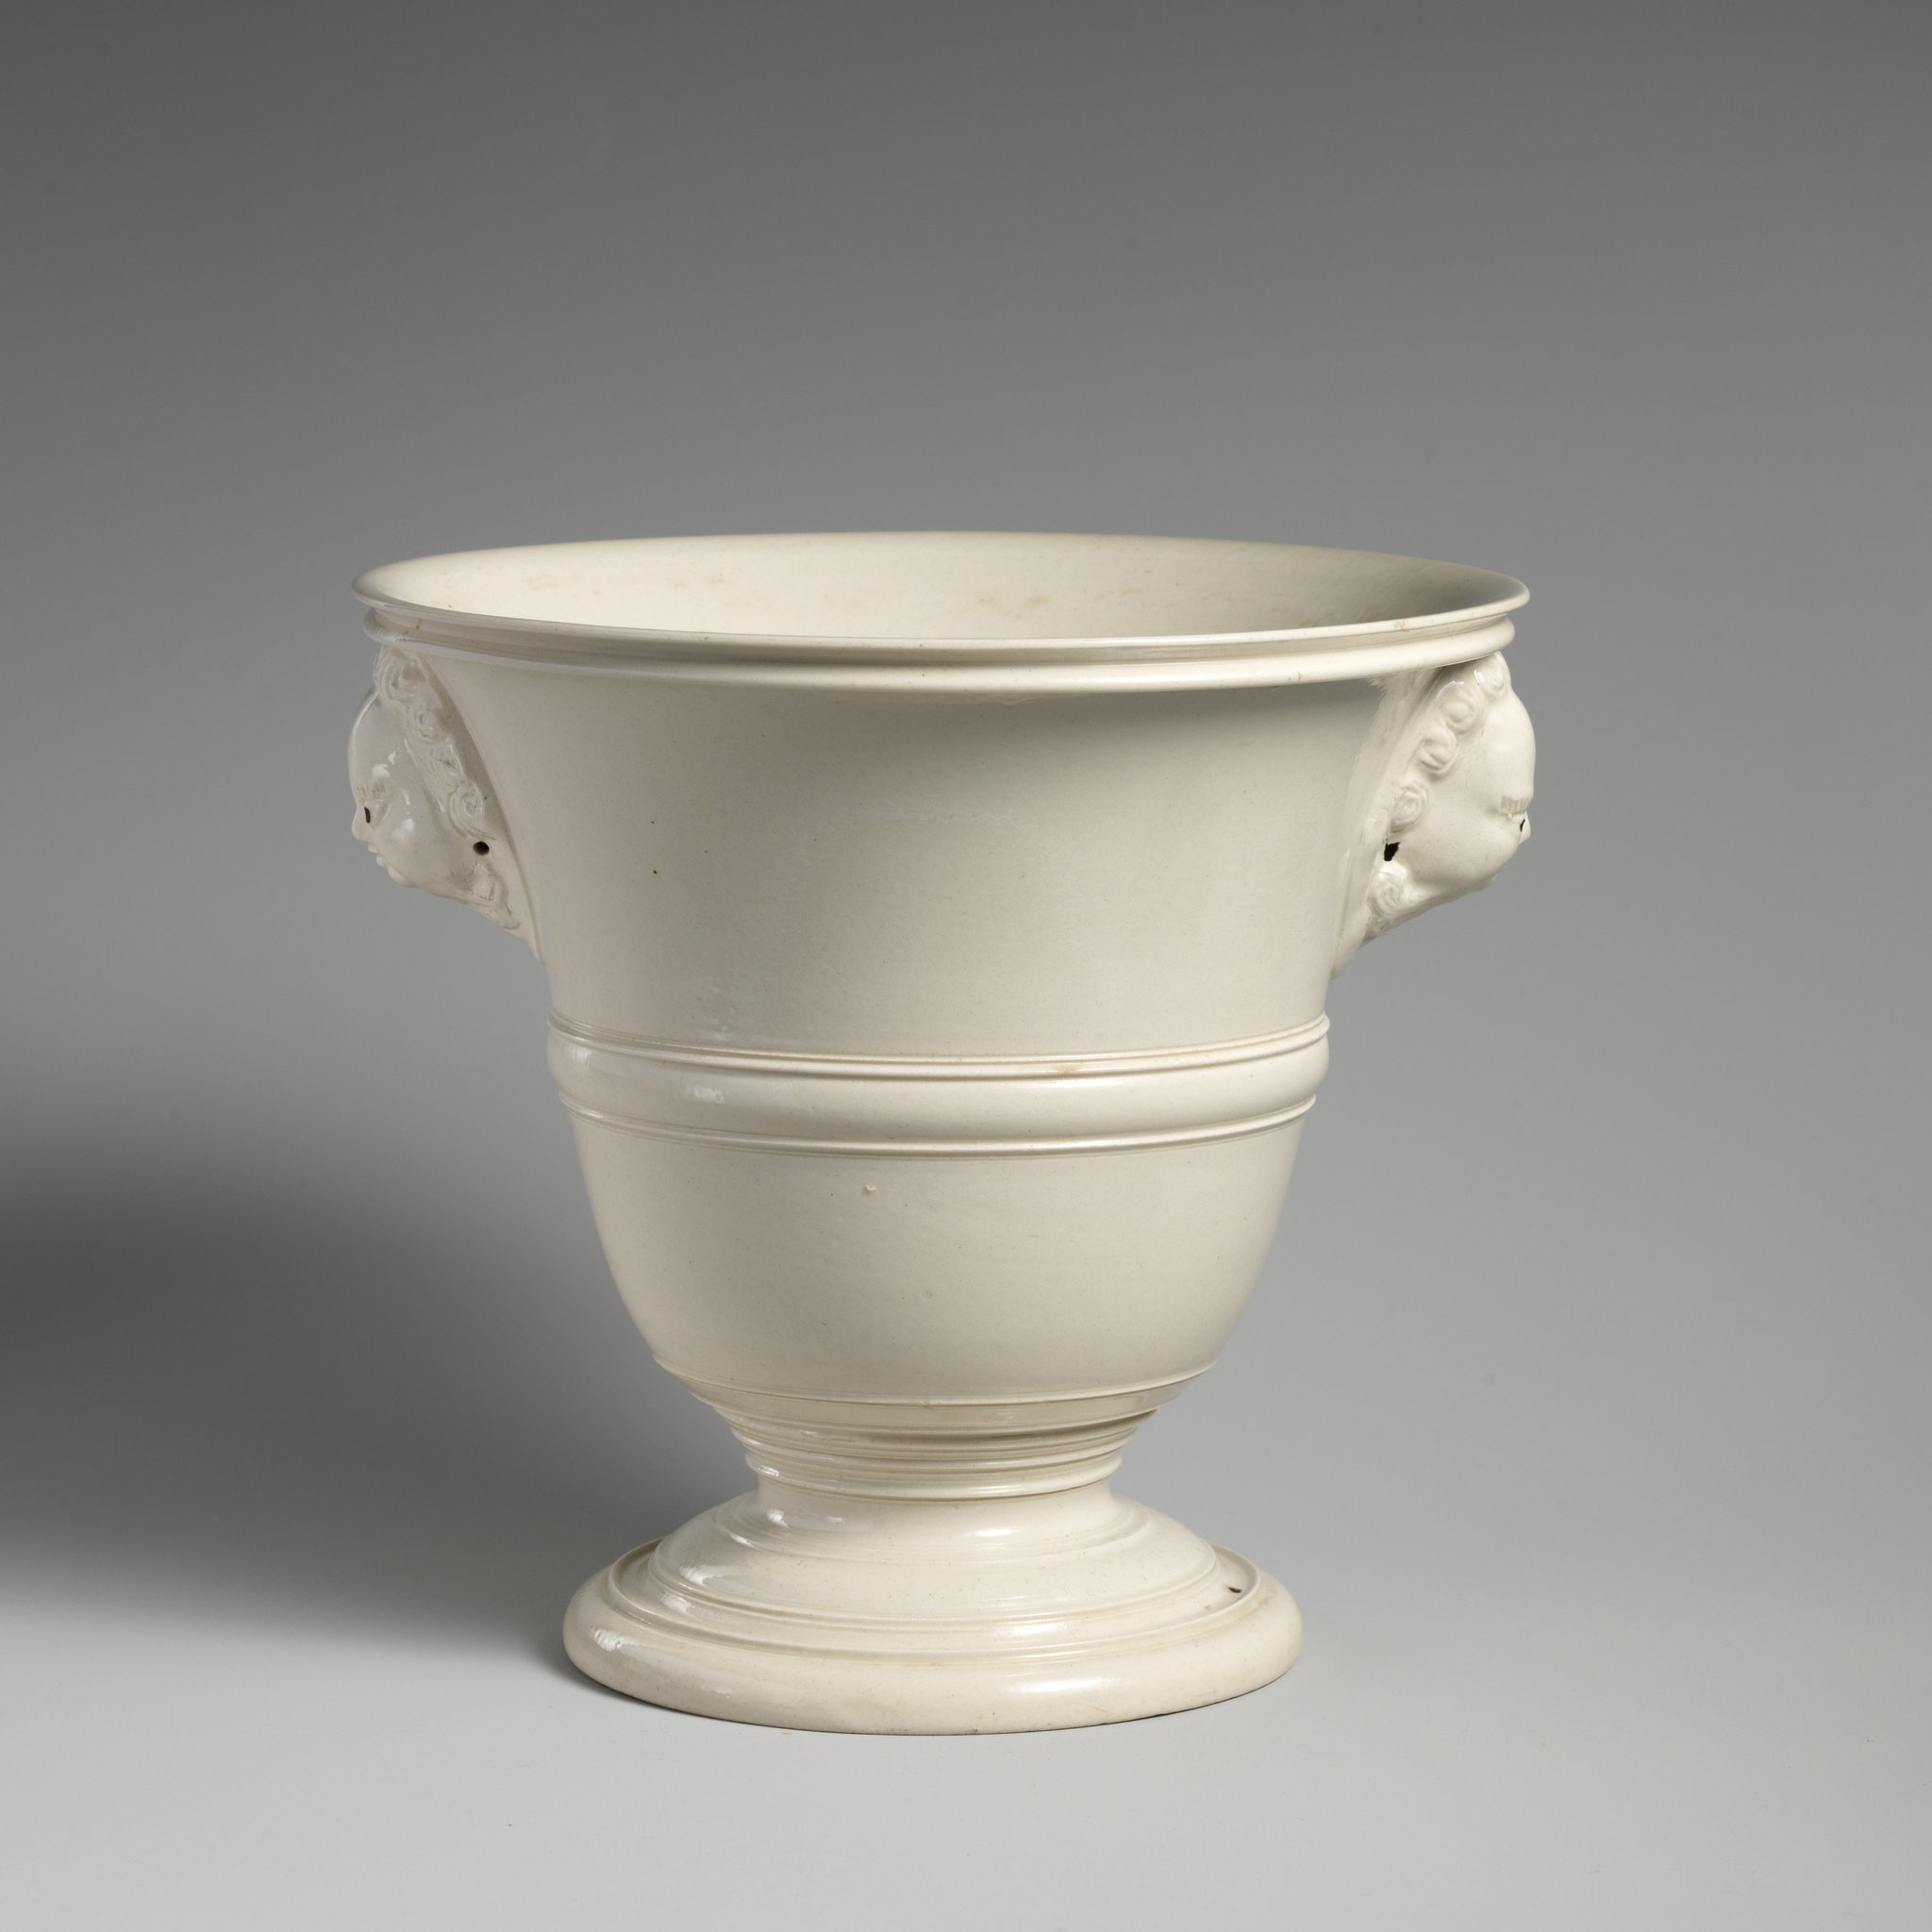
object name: cachepot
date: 1740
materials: stoneware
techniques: salt glaze